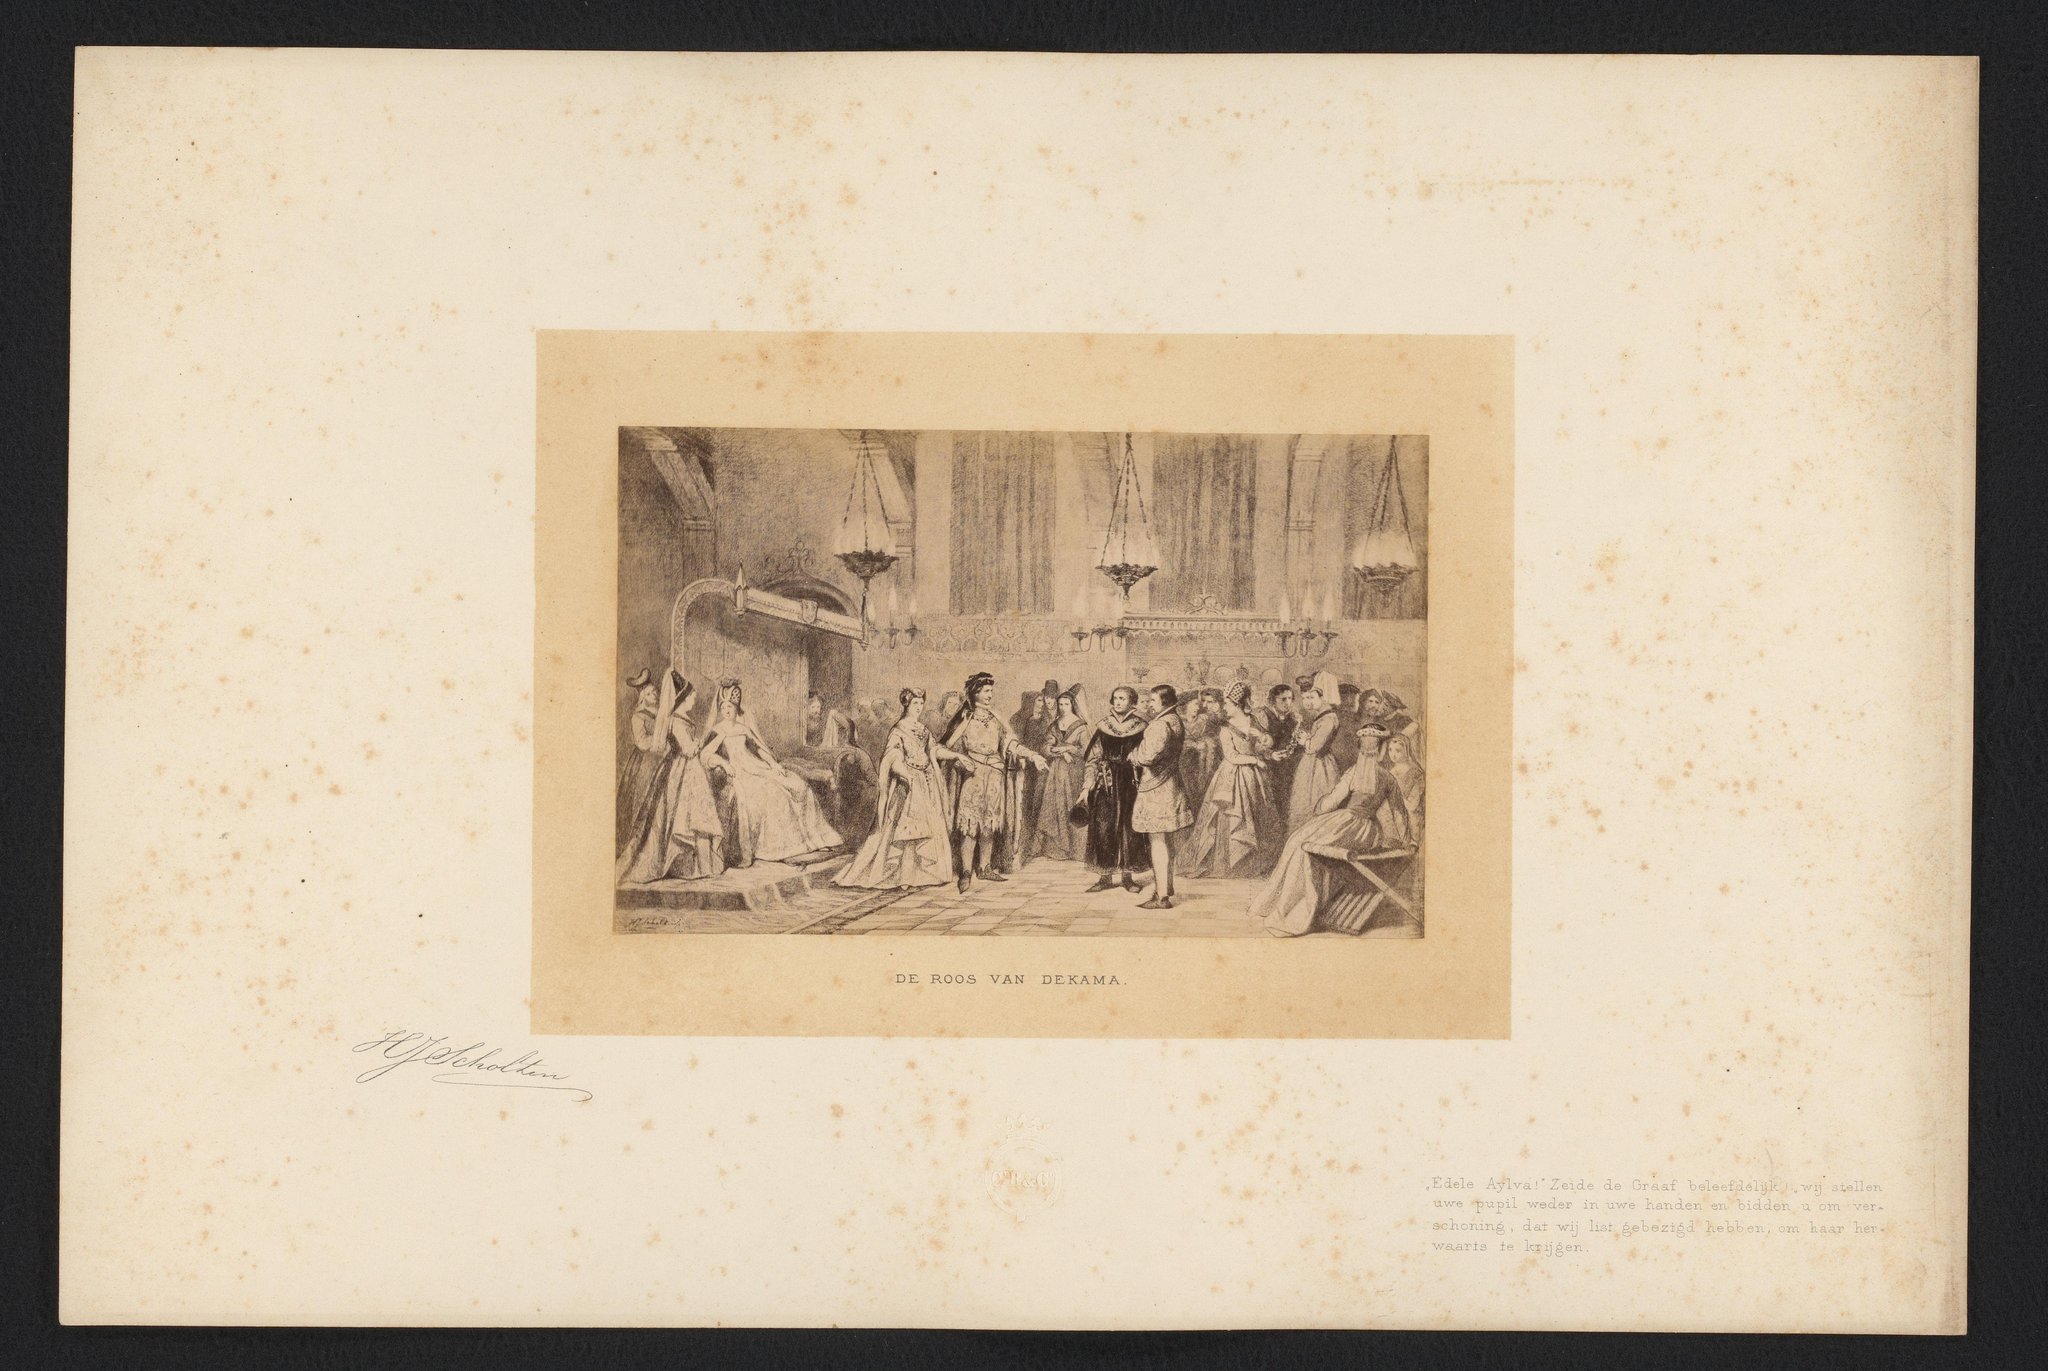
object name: photograph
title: Fotoreproductie van een tekening van een troonzaal door H.J. Scholten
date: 1865-1870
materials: cardboard, paper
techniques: albumen print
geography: haarlem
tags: throne-room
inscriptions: signature: ‘HJ Scholten’, inscription: ‘"Edele Aylva!" Zeide (...) waarts te krijgen.’, check stamp: ‘Ch. B & C.’